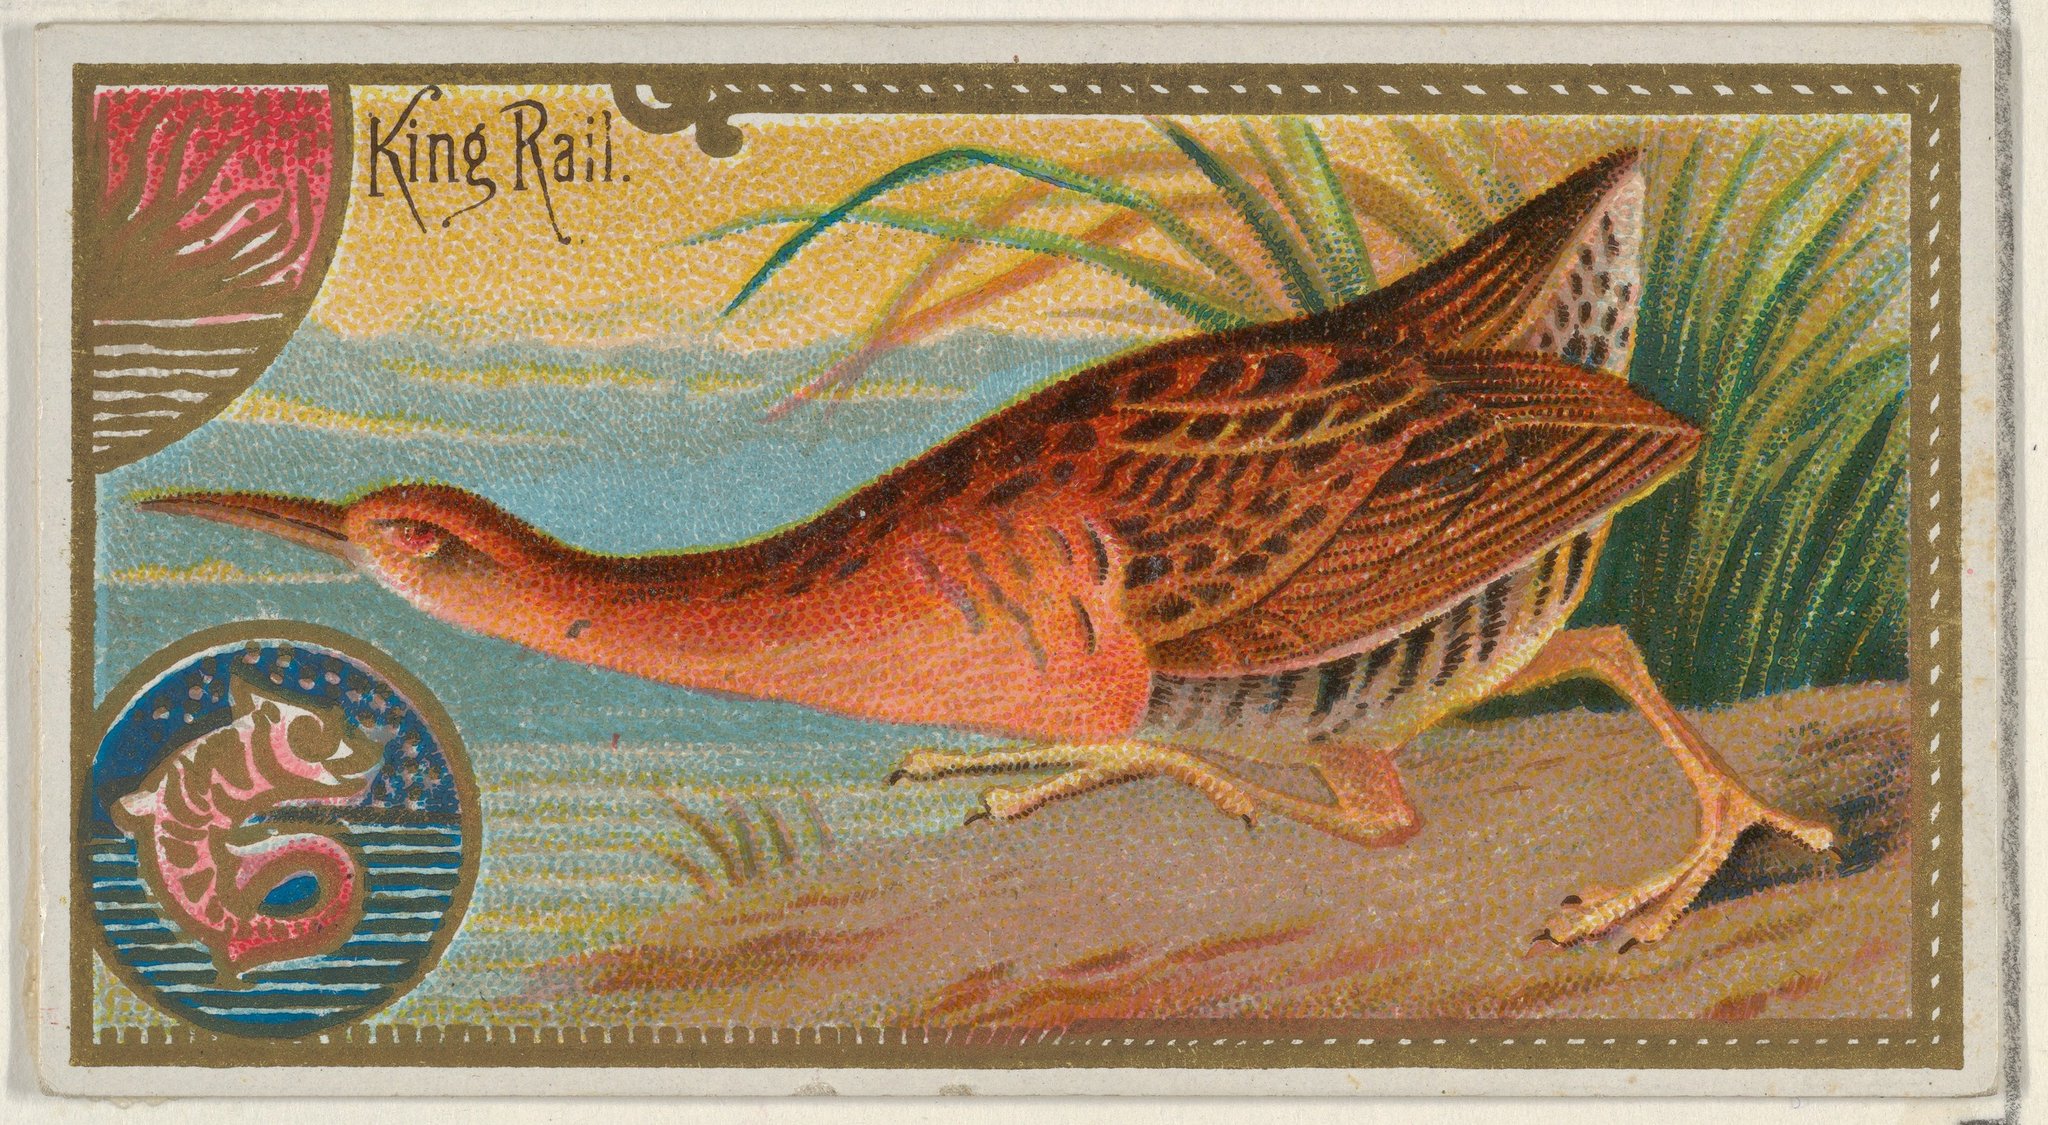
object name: print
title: King Rail, from the Game Birds series (N13) for Allen & Ginter Cigarettes Brands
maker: allen & ginter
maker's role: publisher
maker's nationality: american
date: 1889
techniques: color lithograph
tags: birds